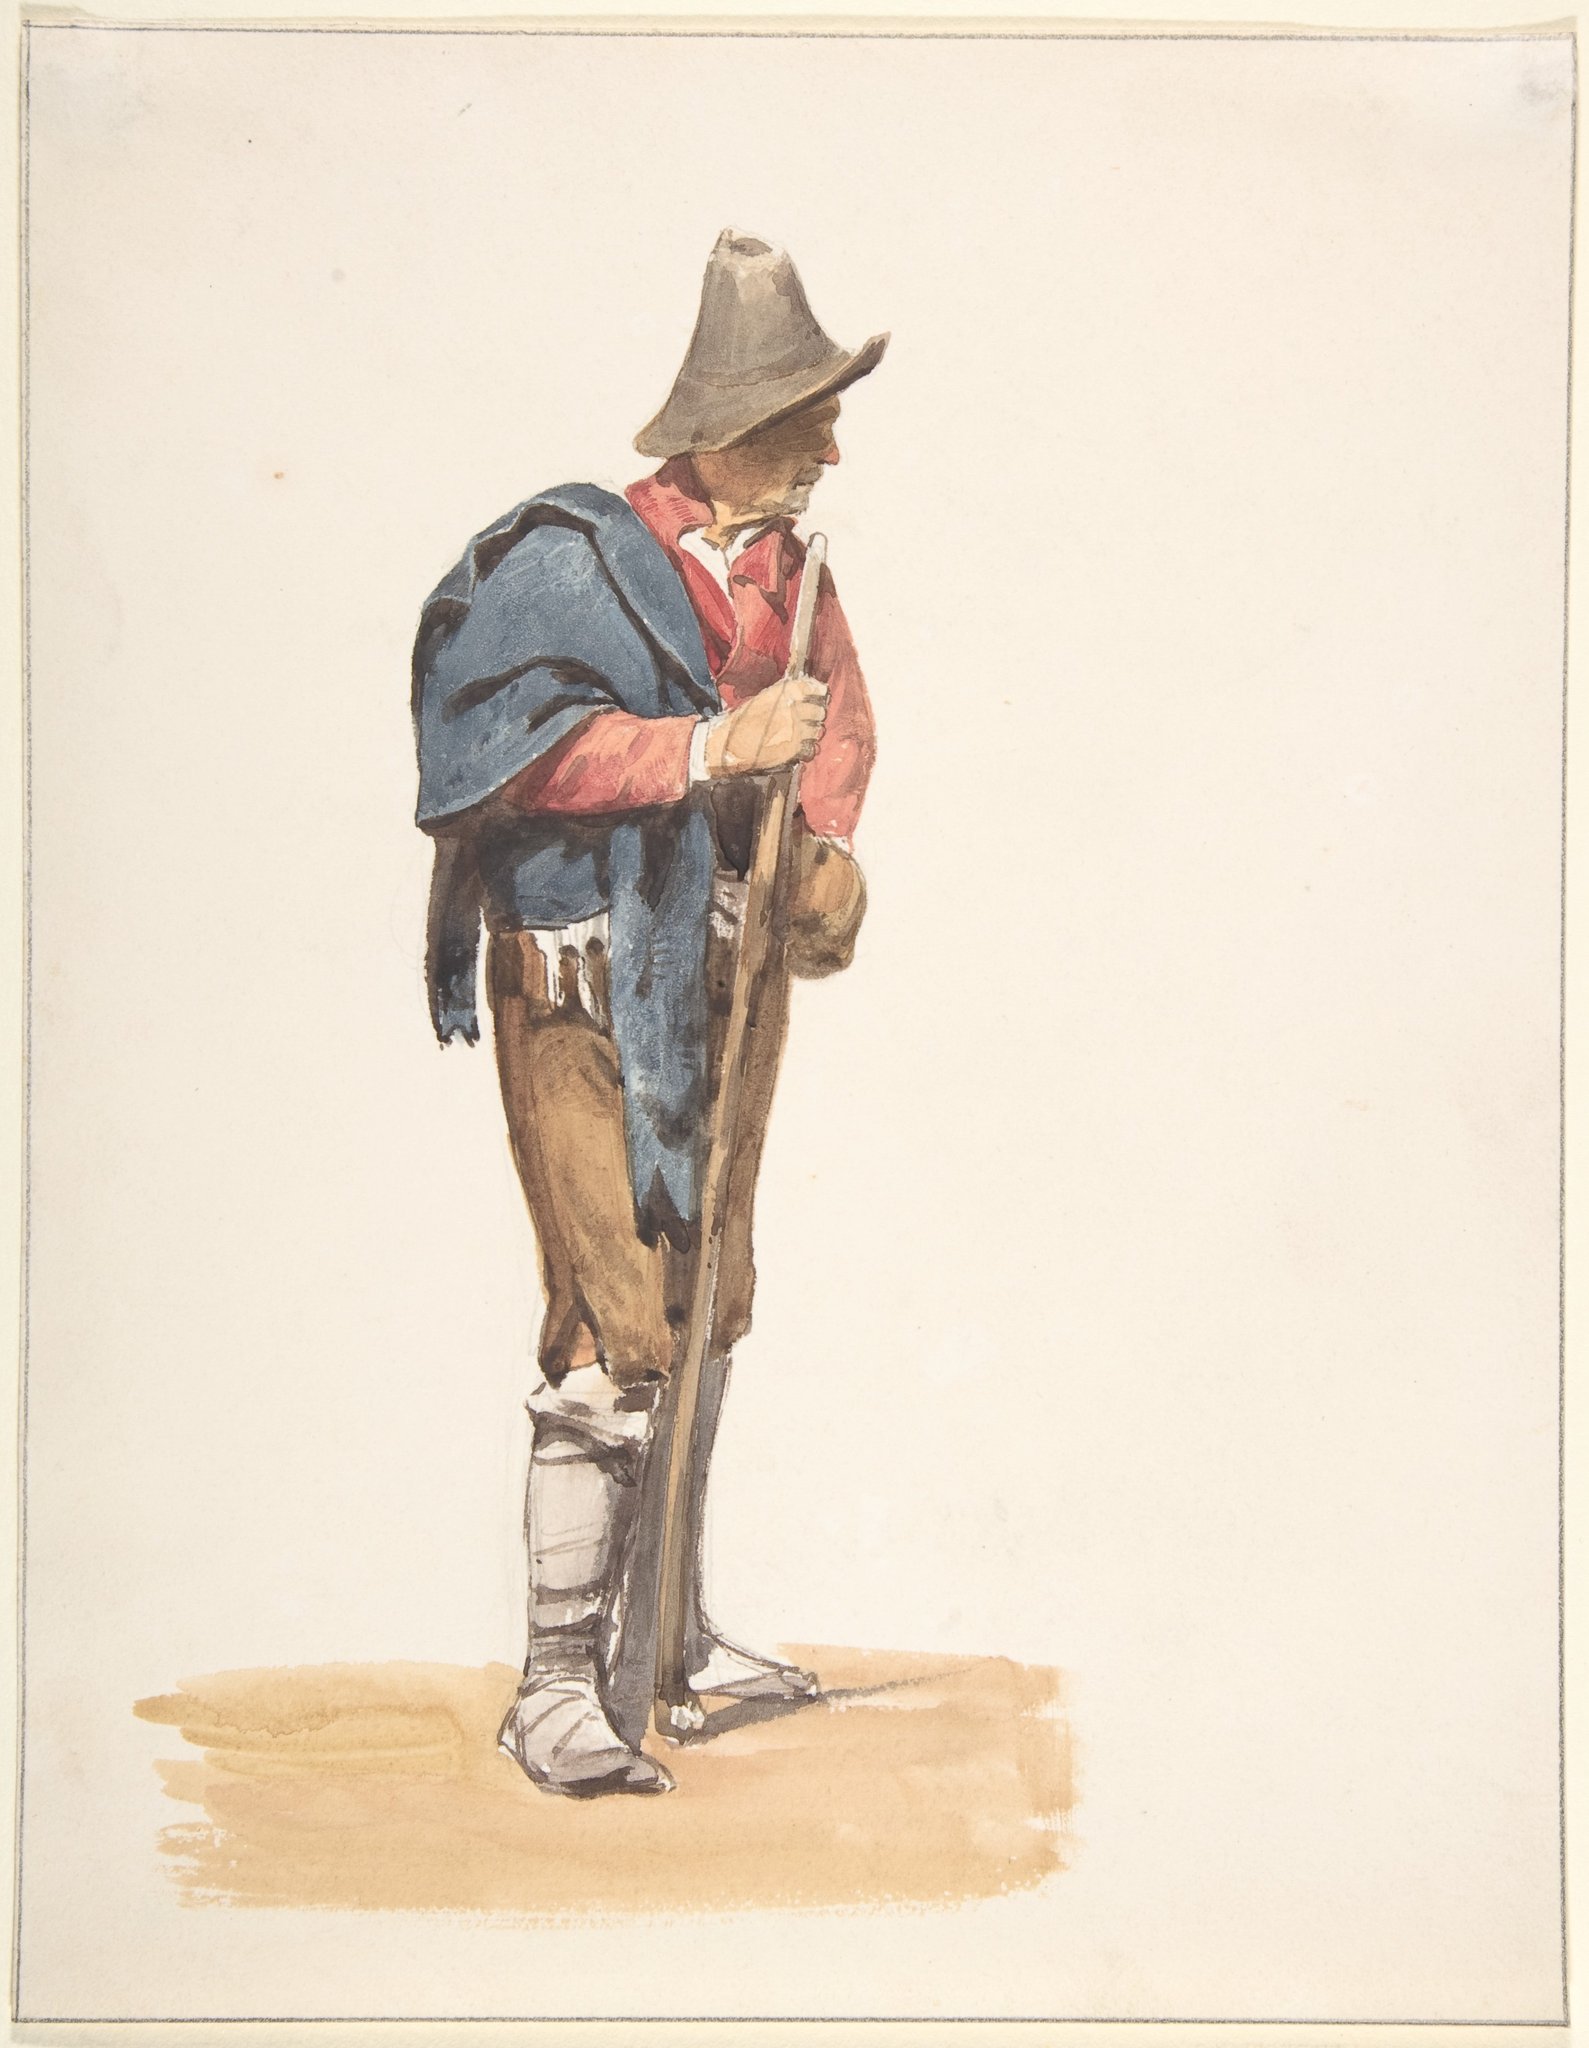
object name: drawing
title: Italian Farmer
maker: pierre louis dubourcq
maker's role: artist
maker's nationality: dutch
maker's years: 1815-1873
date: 1834-1866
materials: graphite, watercolor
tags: men,farmers